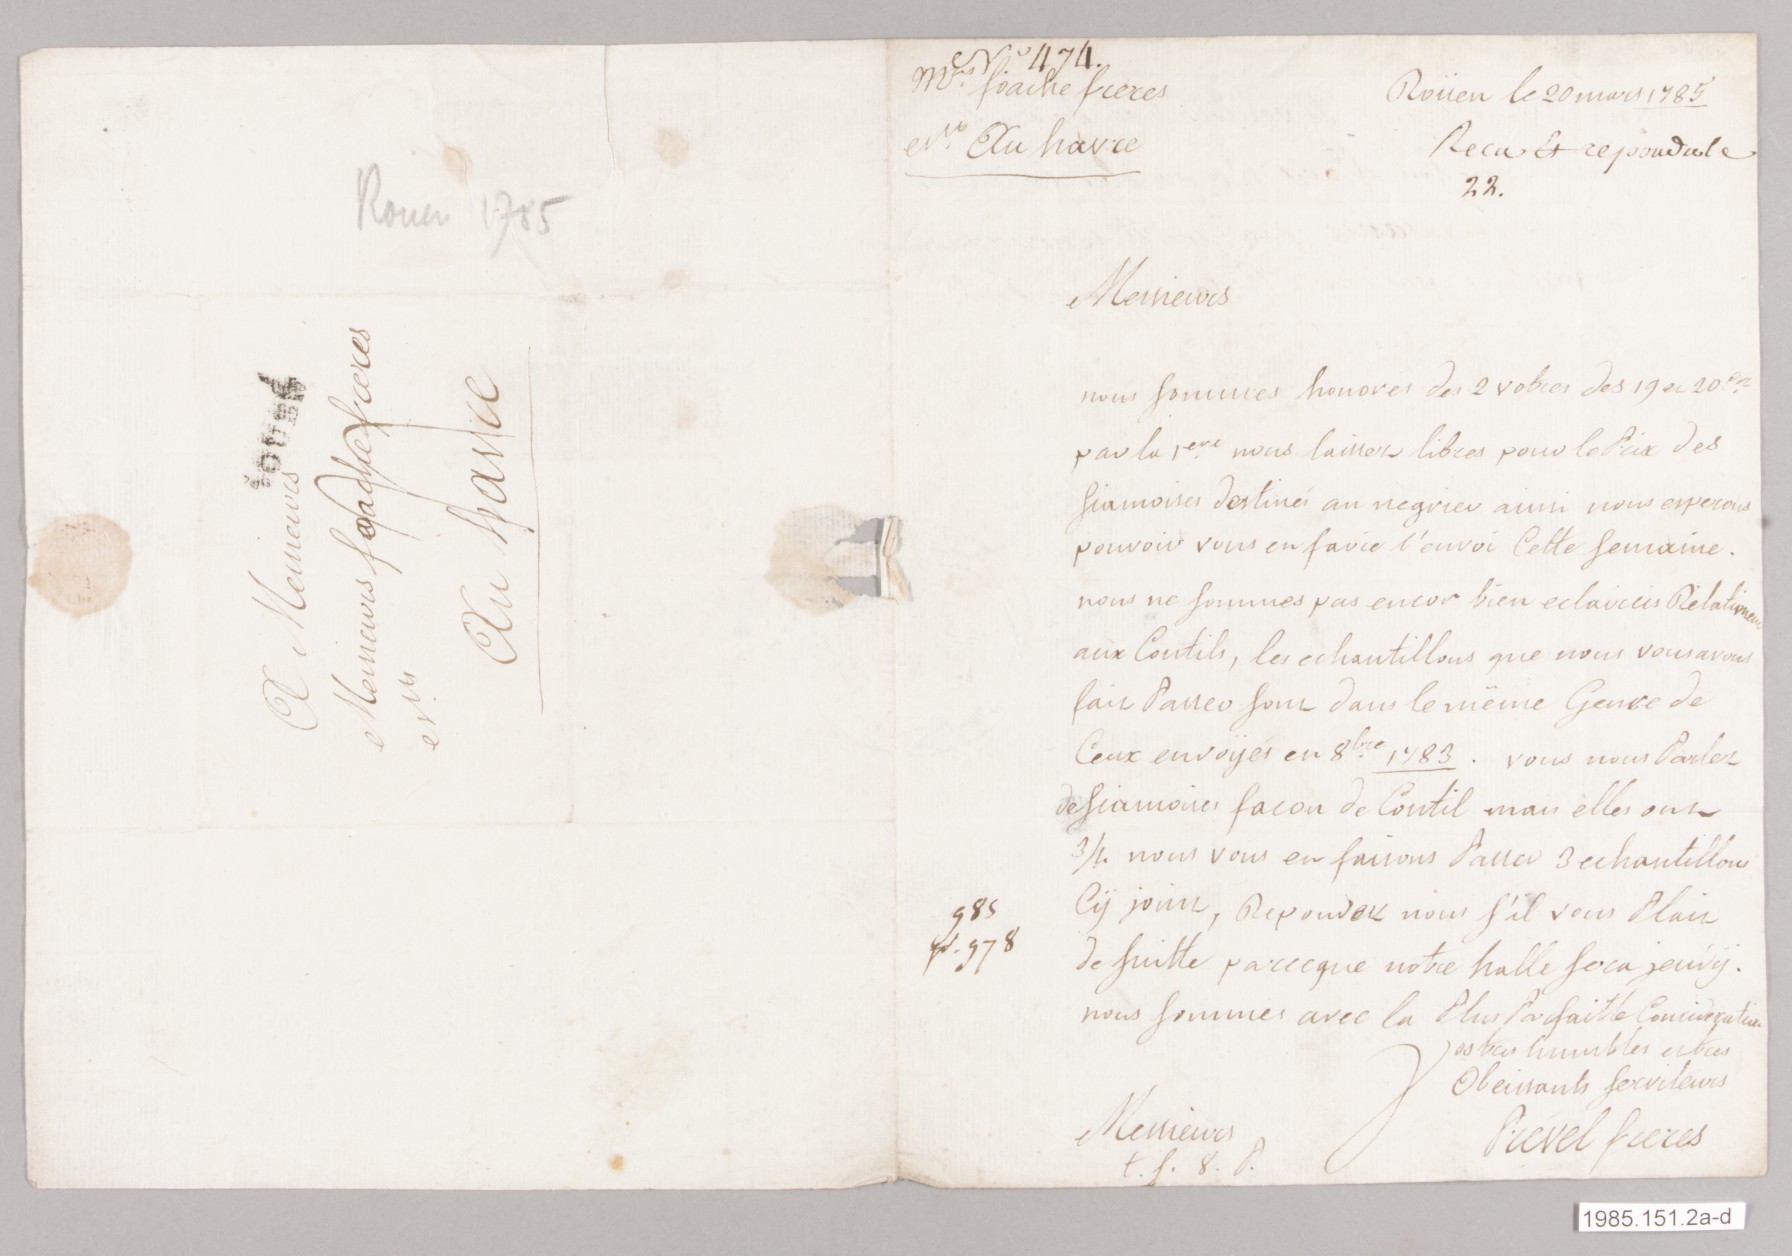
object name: sample and letter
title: Textile swatch to accompany letter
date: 1767-1800